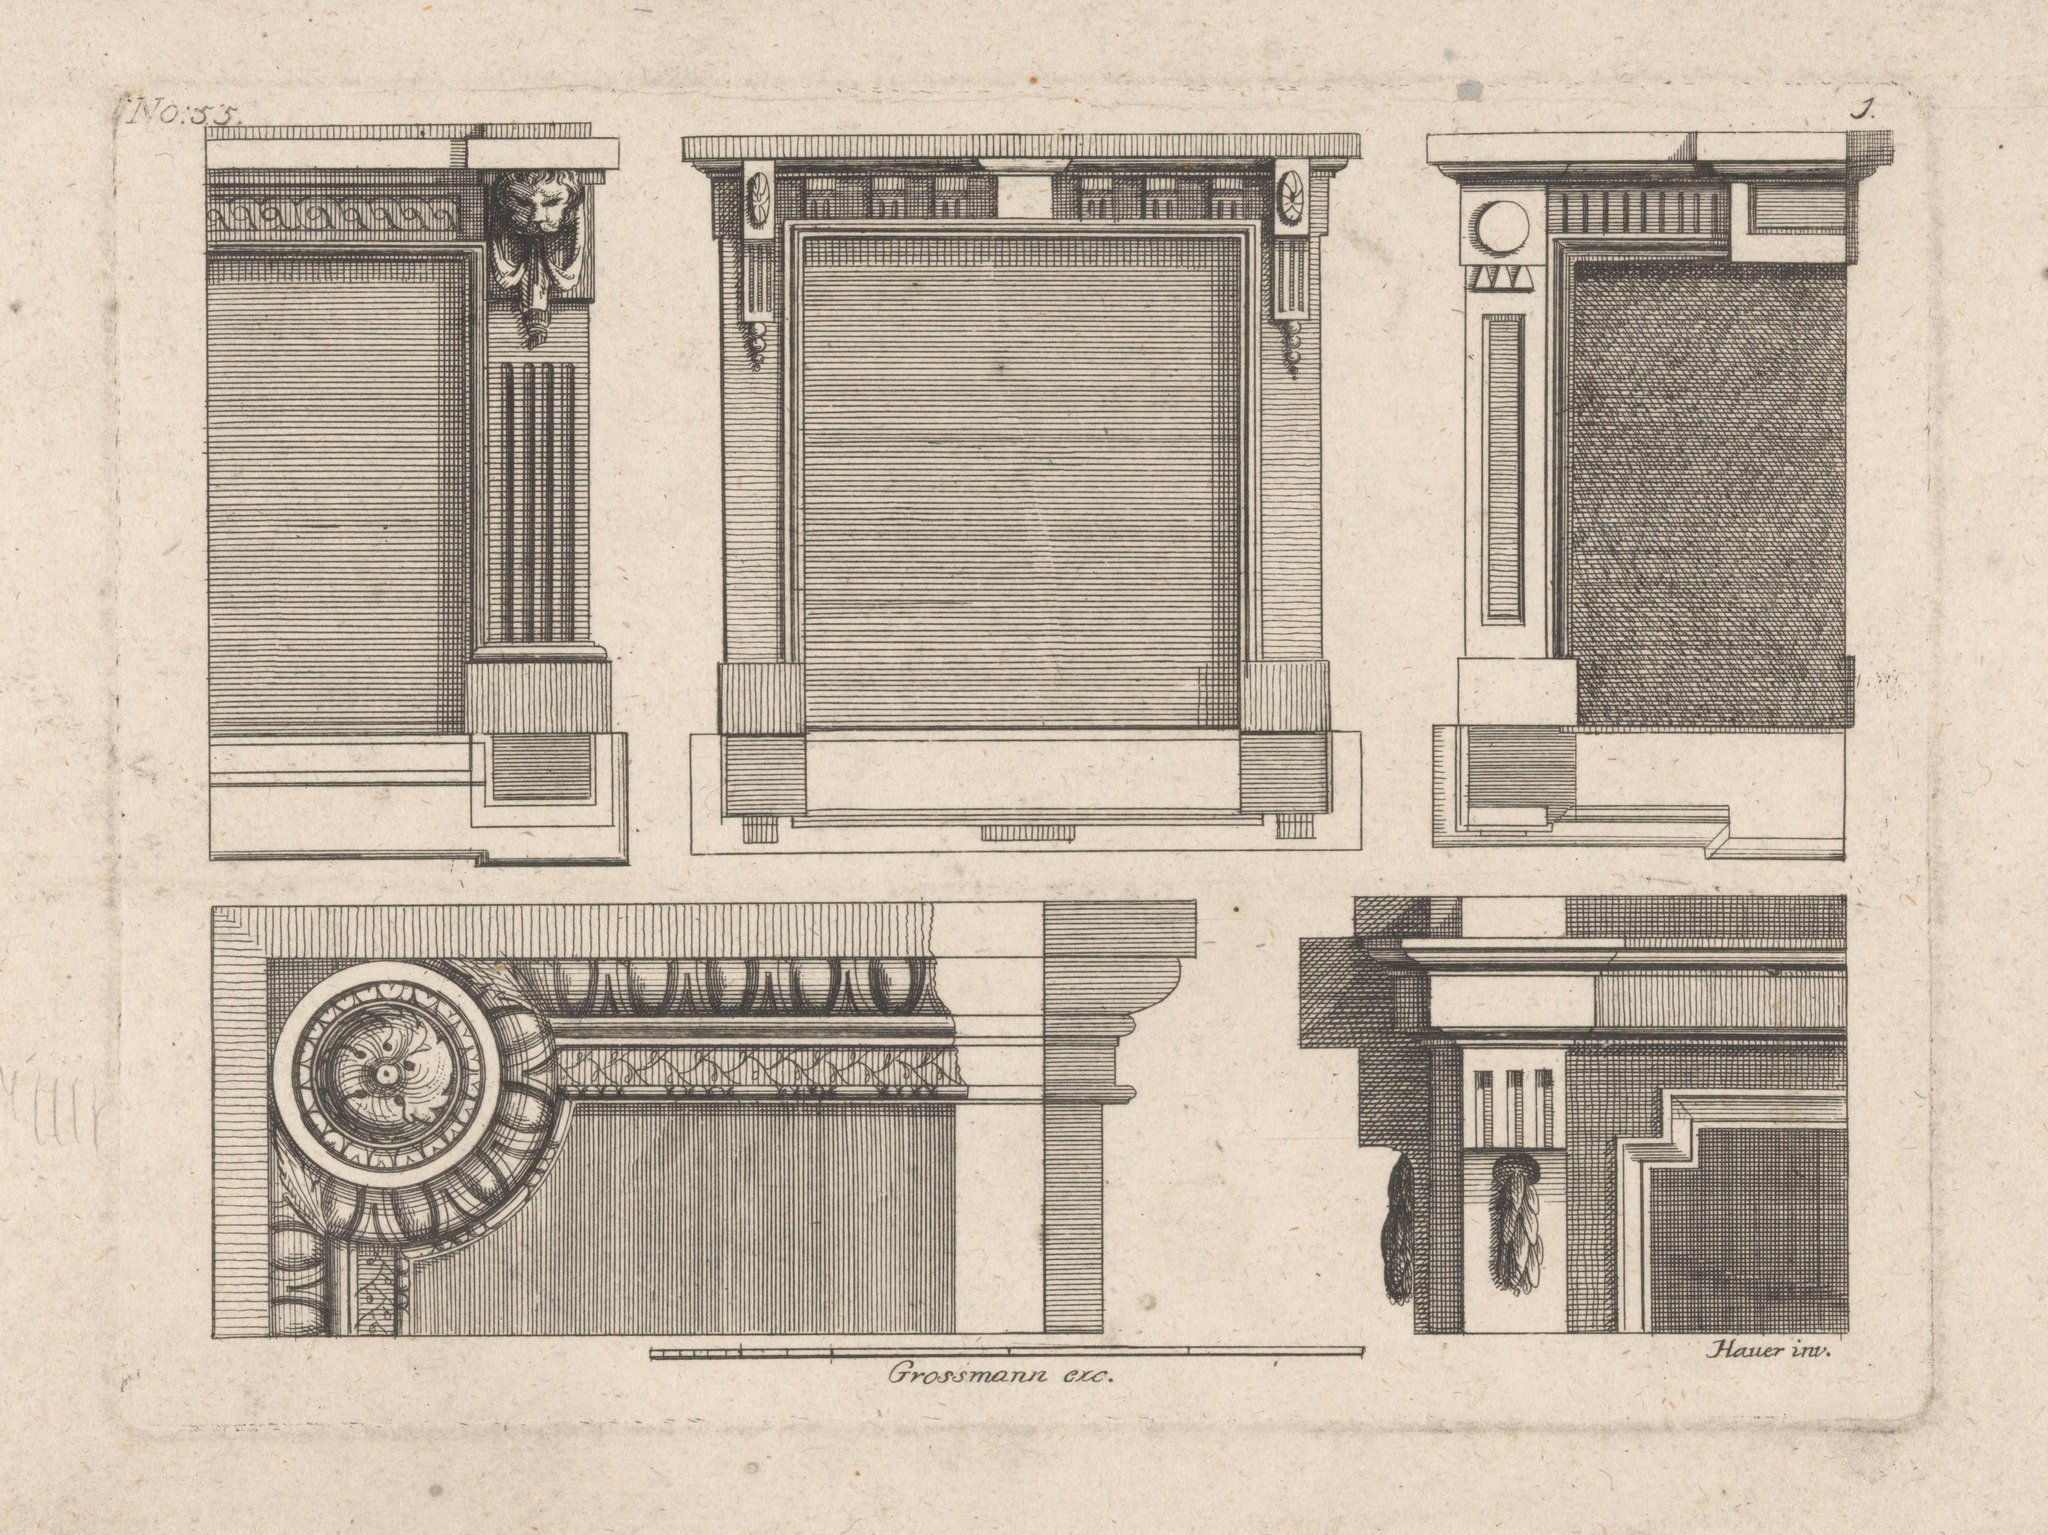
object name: ornament print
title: Omlijstingen van haarden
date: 1758-1798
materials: paper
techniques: engraving, etching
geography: germany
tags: ornaments ~ art (+ framing decorations), open hearth, fire-place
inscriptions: collector's mark: Lugt 2228, collector's mark: Lugt 2760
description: Vijf ontwerpen voor geornamenteerde omlijstingen van haarden, met bloemmotieven en leeuwenkop. Uitgeversnummer 55.